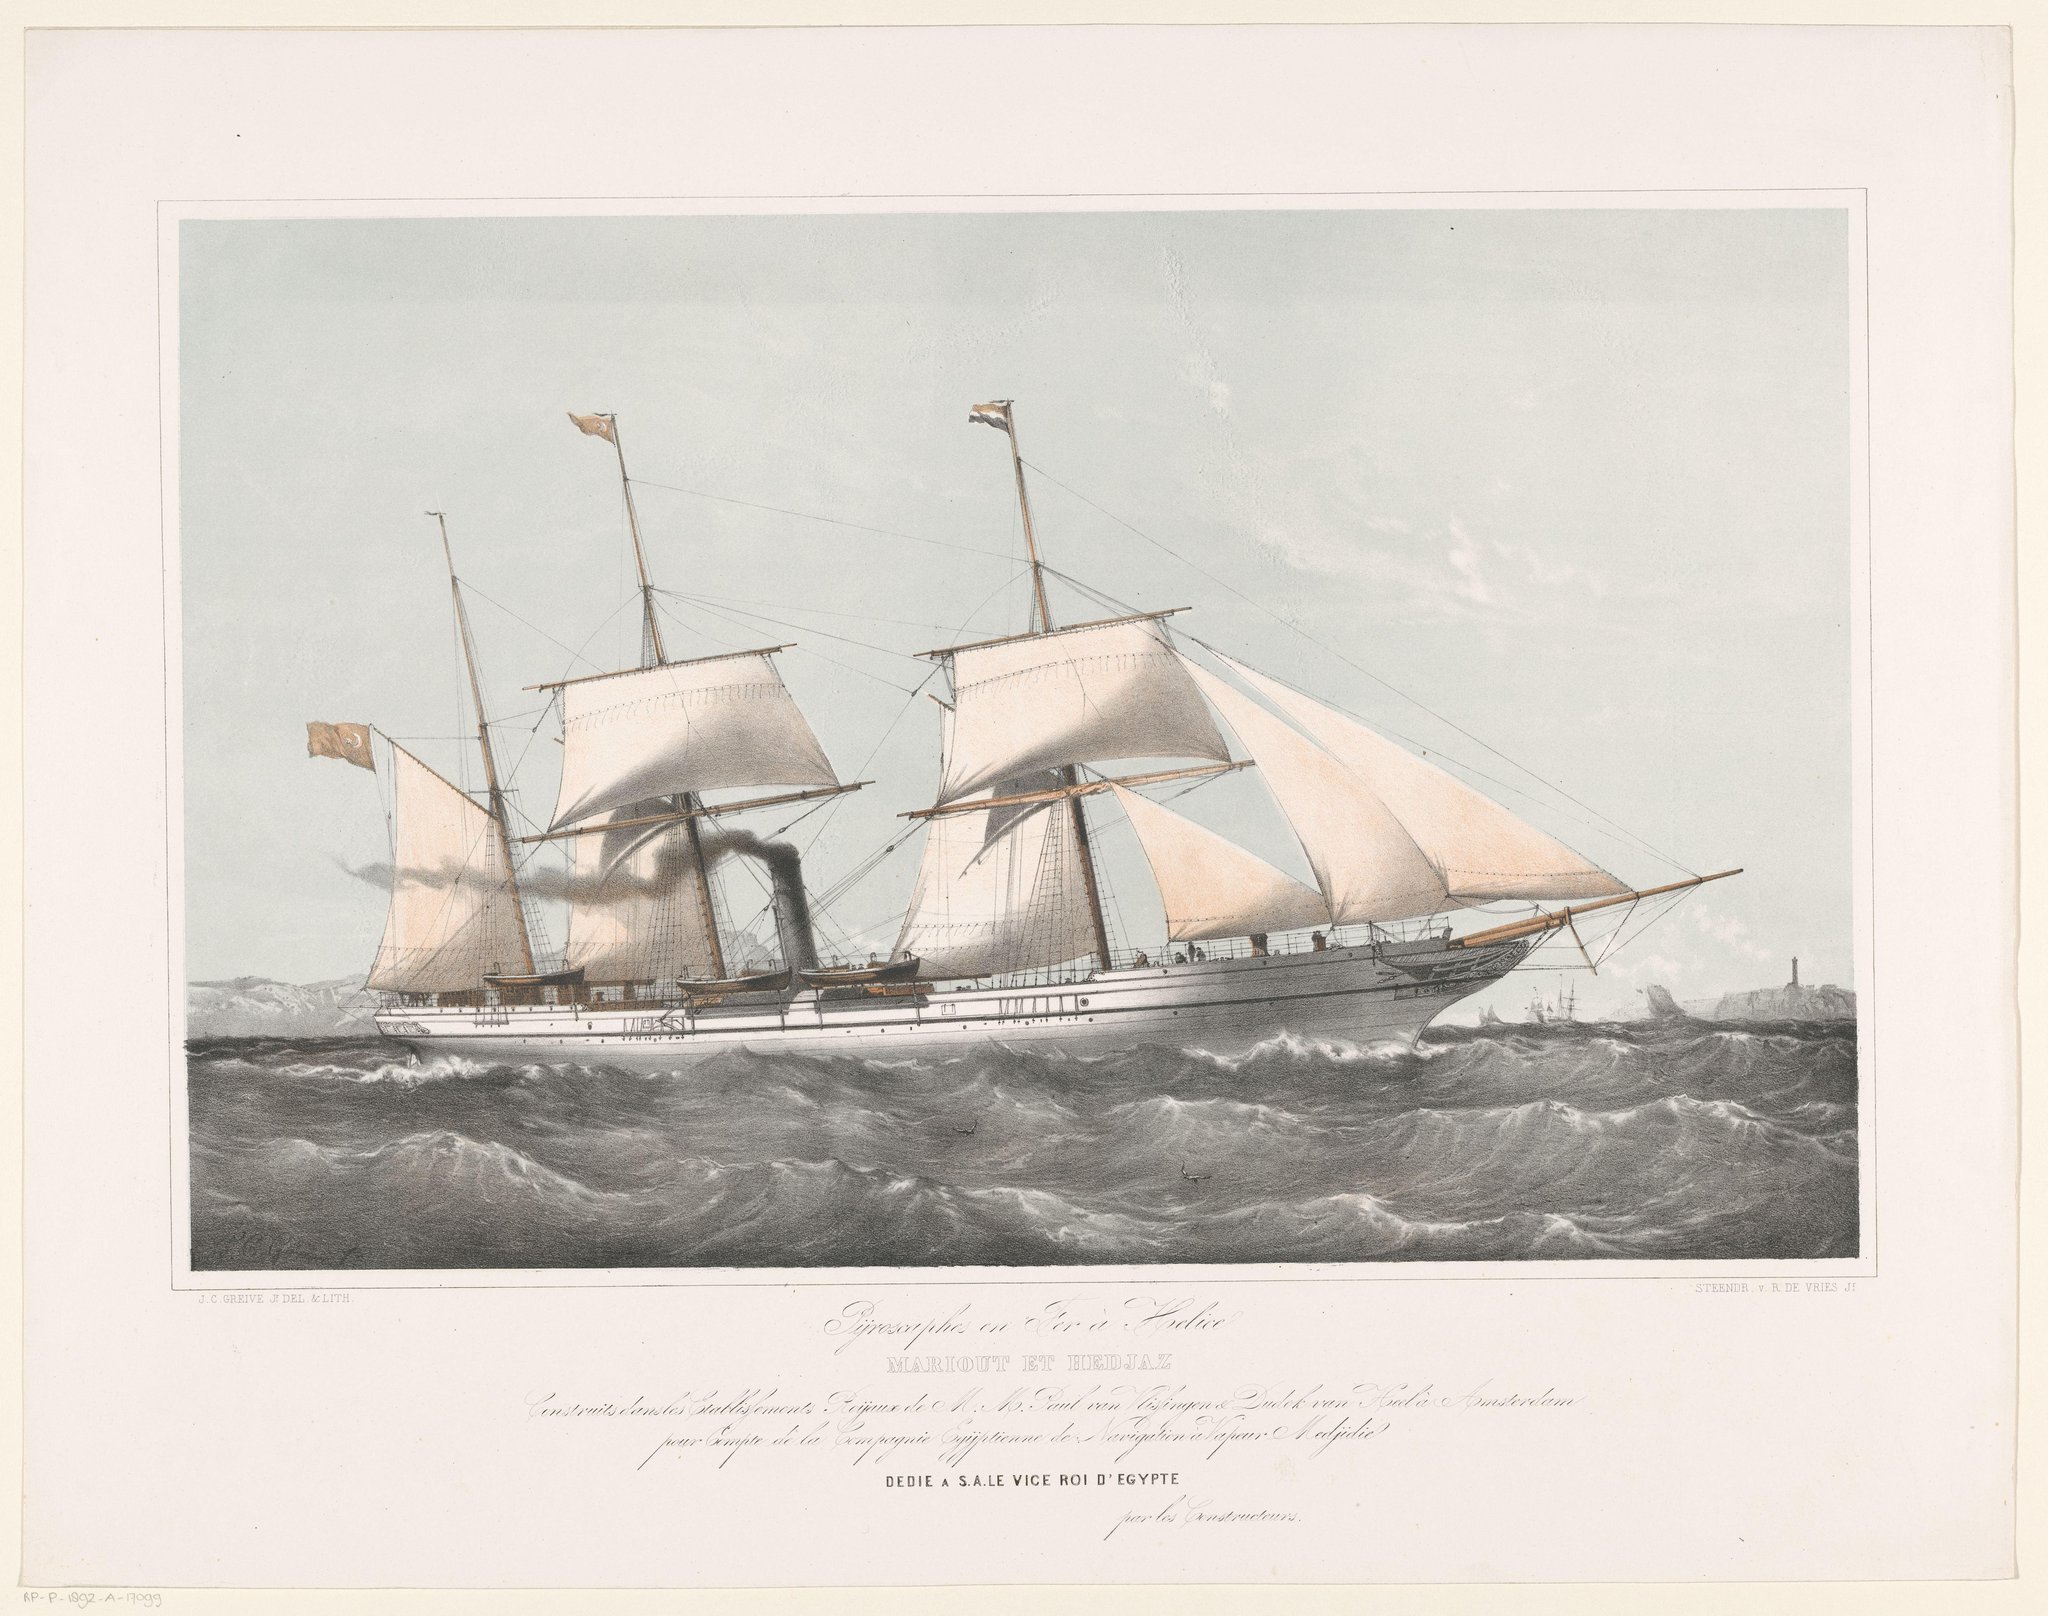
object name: print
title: Pijroscaphes en Fer à Helice Mariout et Hedjaz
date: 1847-1874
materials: paper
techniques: tone lithography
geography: amsterdam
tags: ships (in general)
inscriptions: collector's mark: Lugt 2228